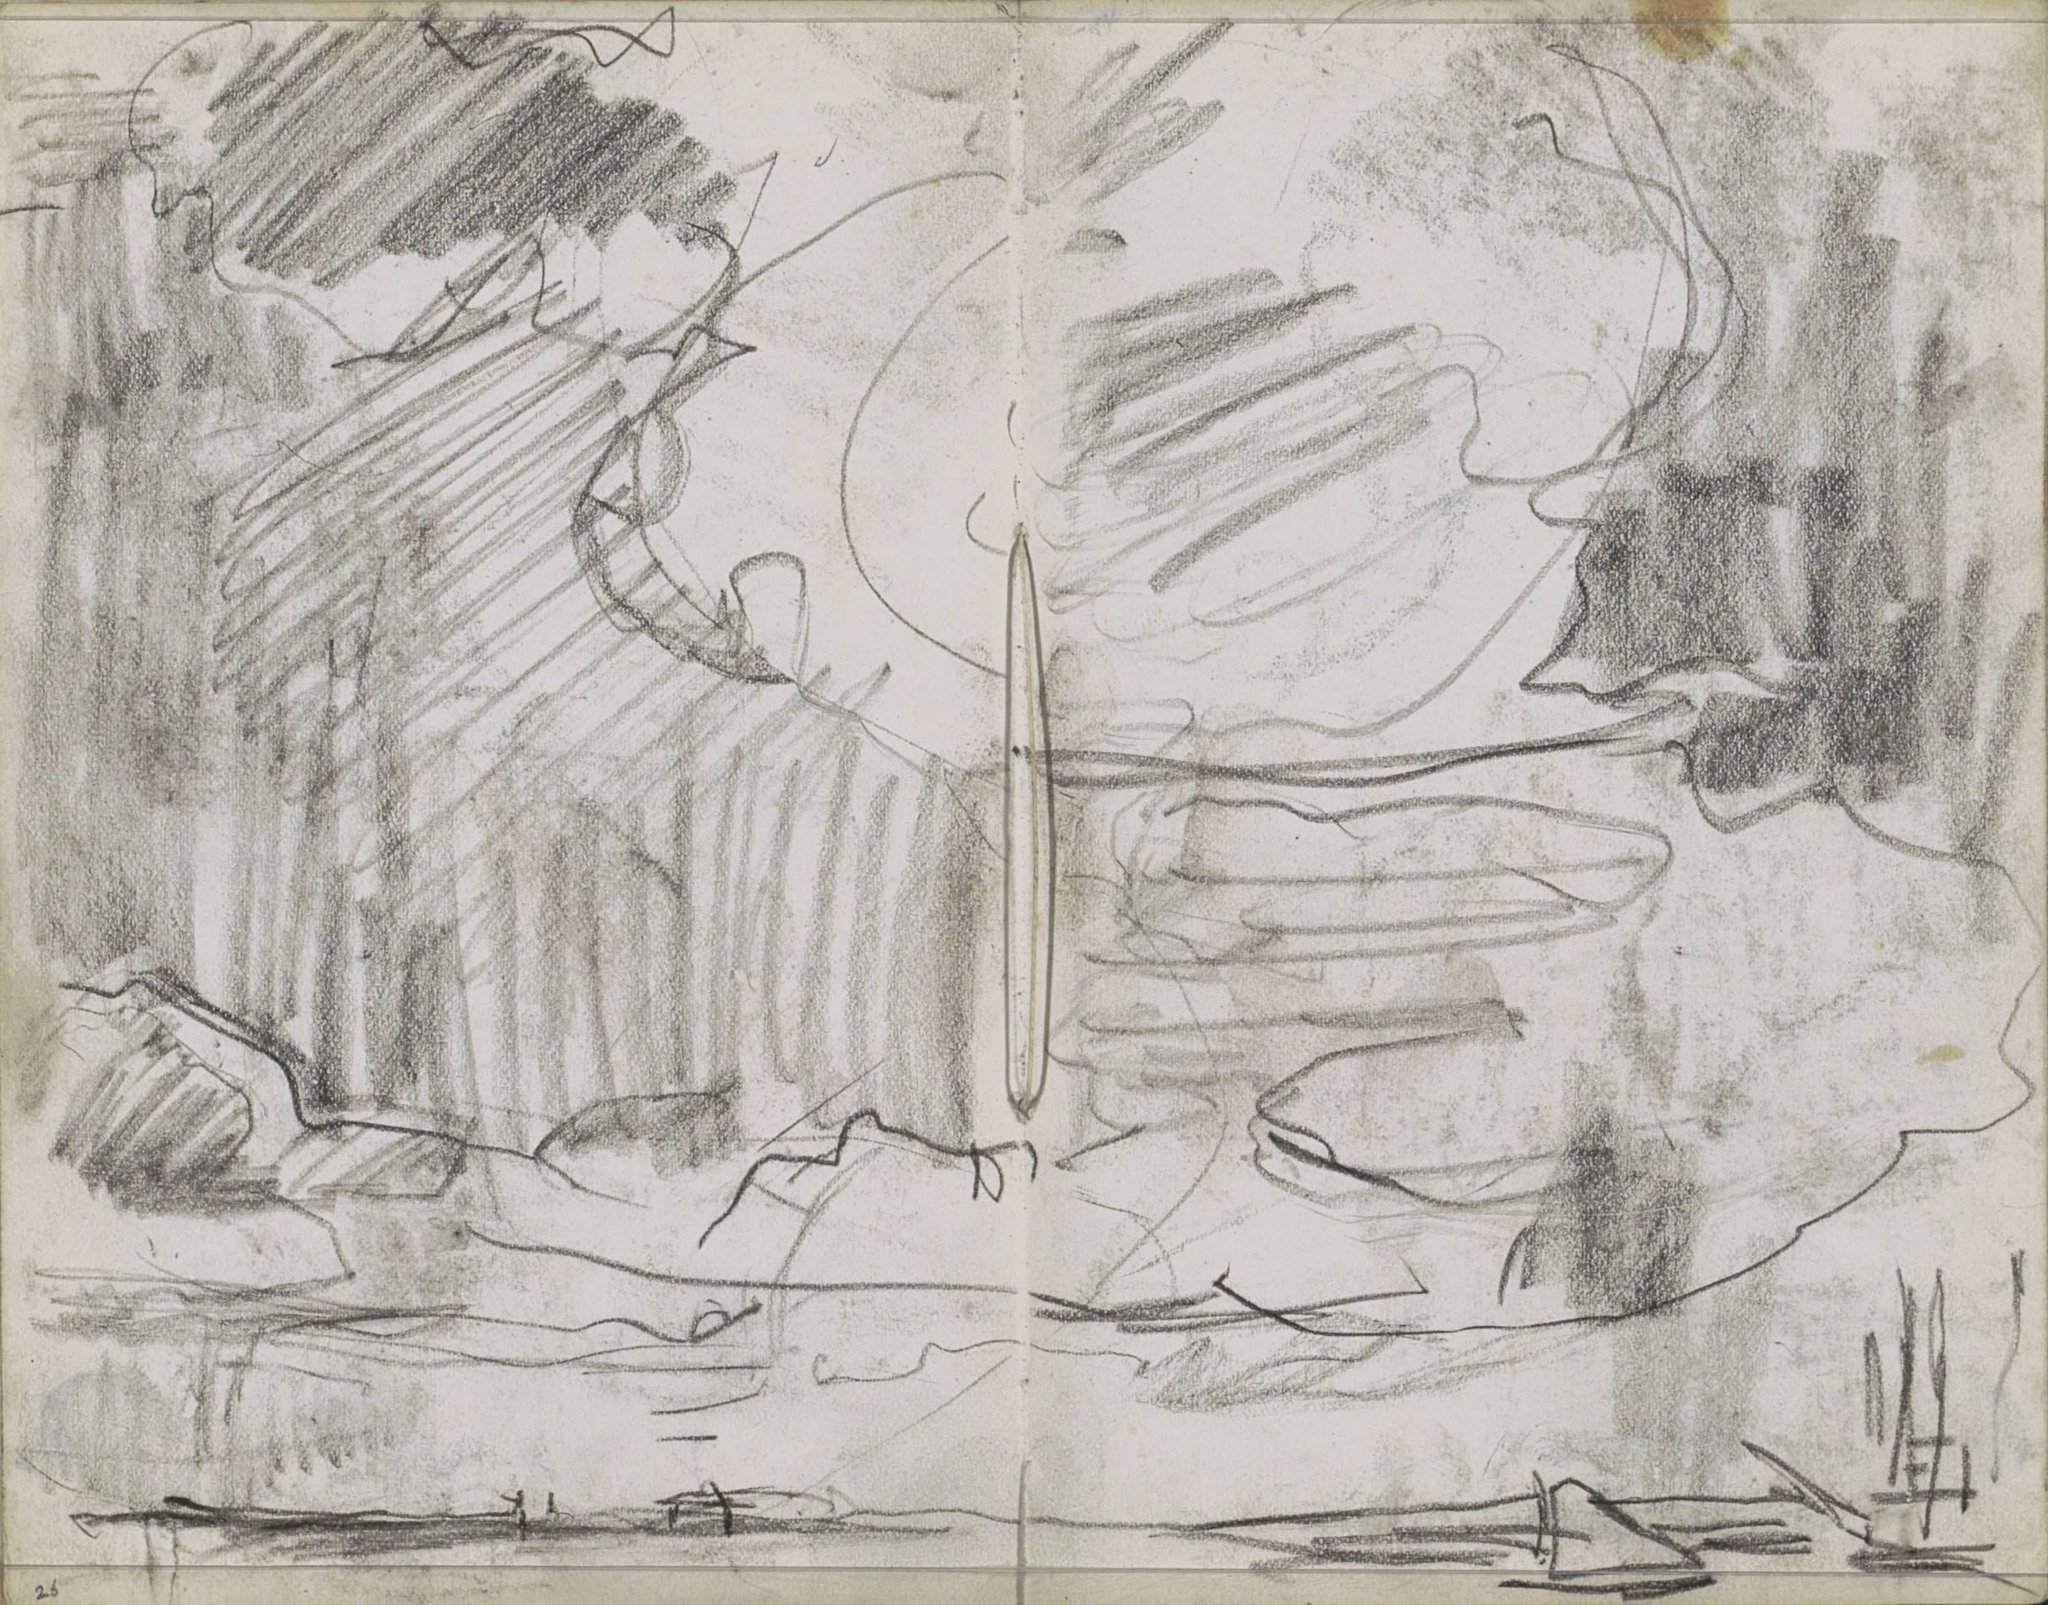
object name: sketchbook leaf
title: Wolkenlucht boven een landschap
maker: isaac israels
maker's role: draughtsman, painter, print maker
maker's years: 1865-1934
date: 1875-1934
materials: chalk, paper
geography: amsterdam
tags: clouds, landscapes in the temperate zone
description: Pagina 26 en pagina 27 uit schetsboek XXIX met 44 pagina's.